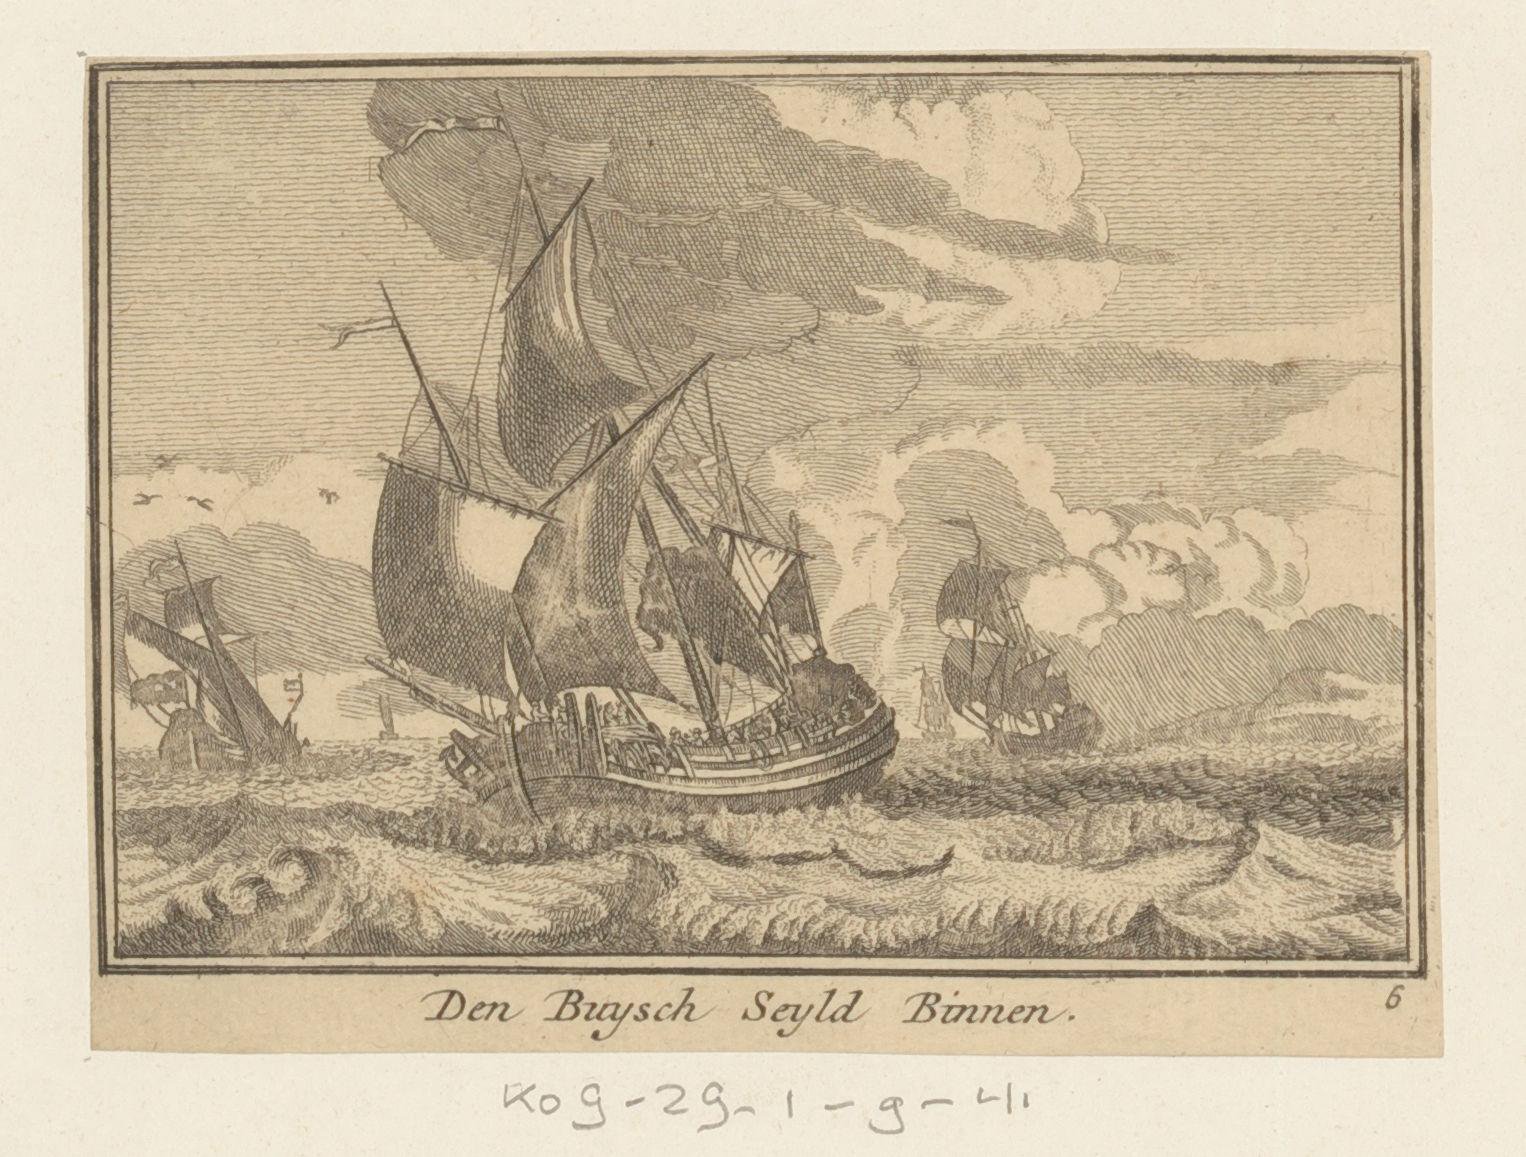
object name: print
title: De Buysch Seyld Binnen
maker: Anonymous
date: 1728-1775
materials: paper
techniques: engraving, etching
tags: harbour, fishing net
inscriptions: collector's mark: Lugt 1641, stamp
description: Prenten zijn een verkleinde versie van de serie Groote Visserij, Visschers Atlas tot Amsterdam. Prenten door Adolf van der Laan, naar tekeningen van Sieuwert van der Meulen en uitgegeven door Pieter Schenk II. De serie bestaat uit zeventien platen over de haringvisserij en zestien platen over de walvisvangst. De serie is waarschijnlijk rond 1720 uitgegeven. De kleine prenten werden met vier voorstellingen op een plaat gedrukt. Elke afbeelding werd genummerd.